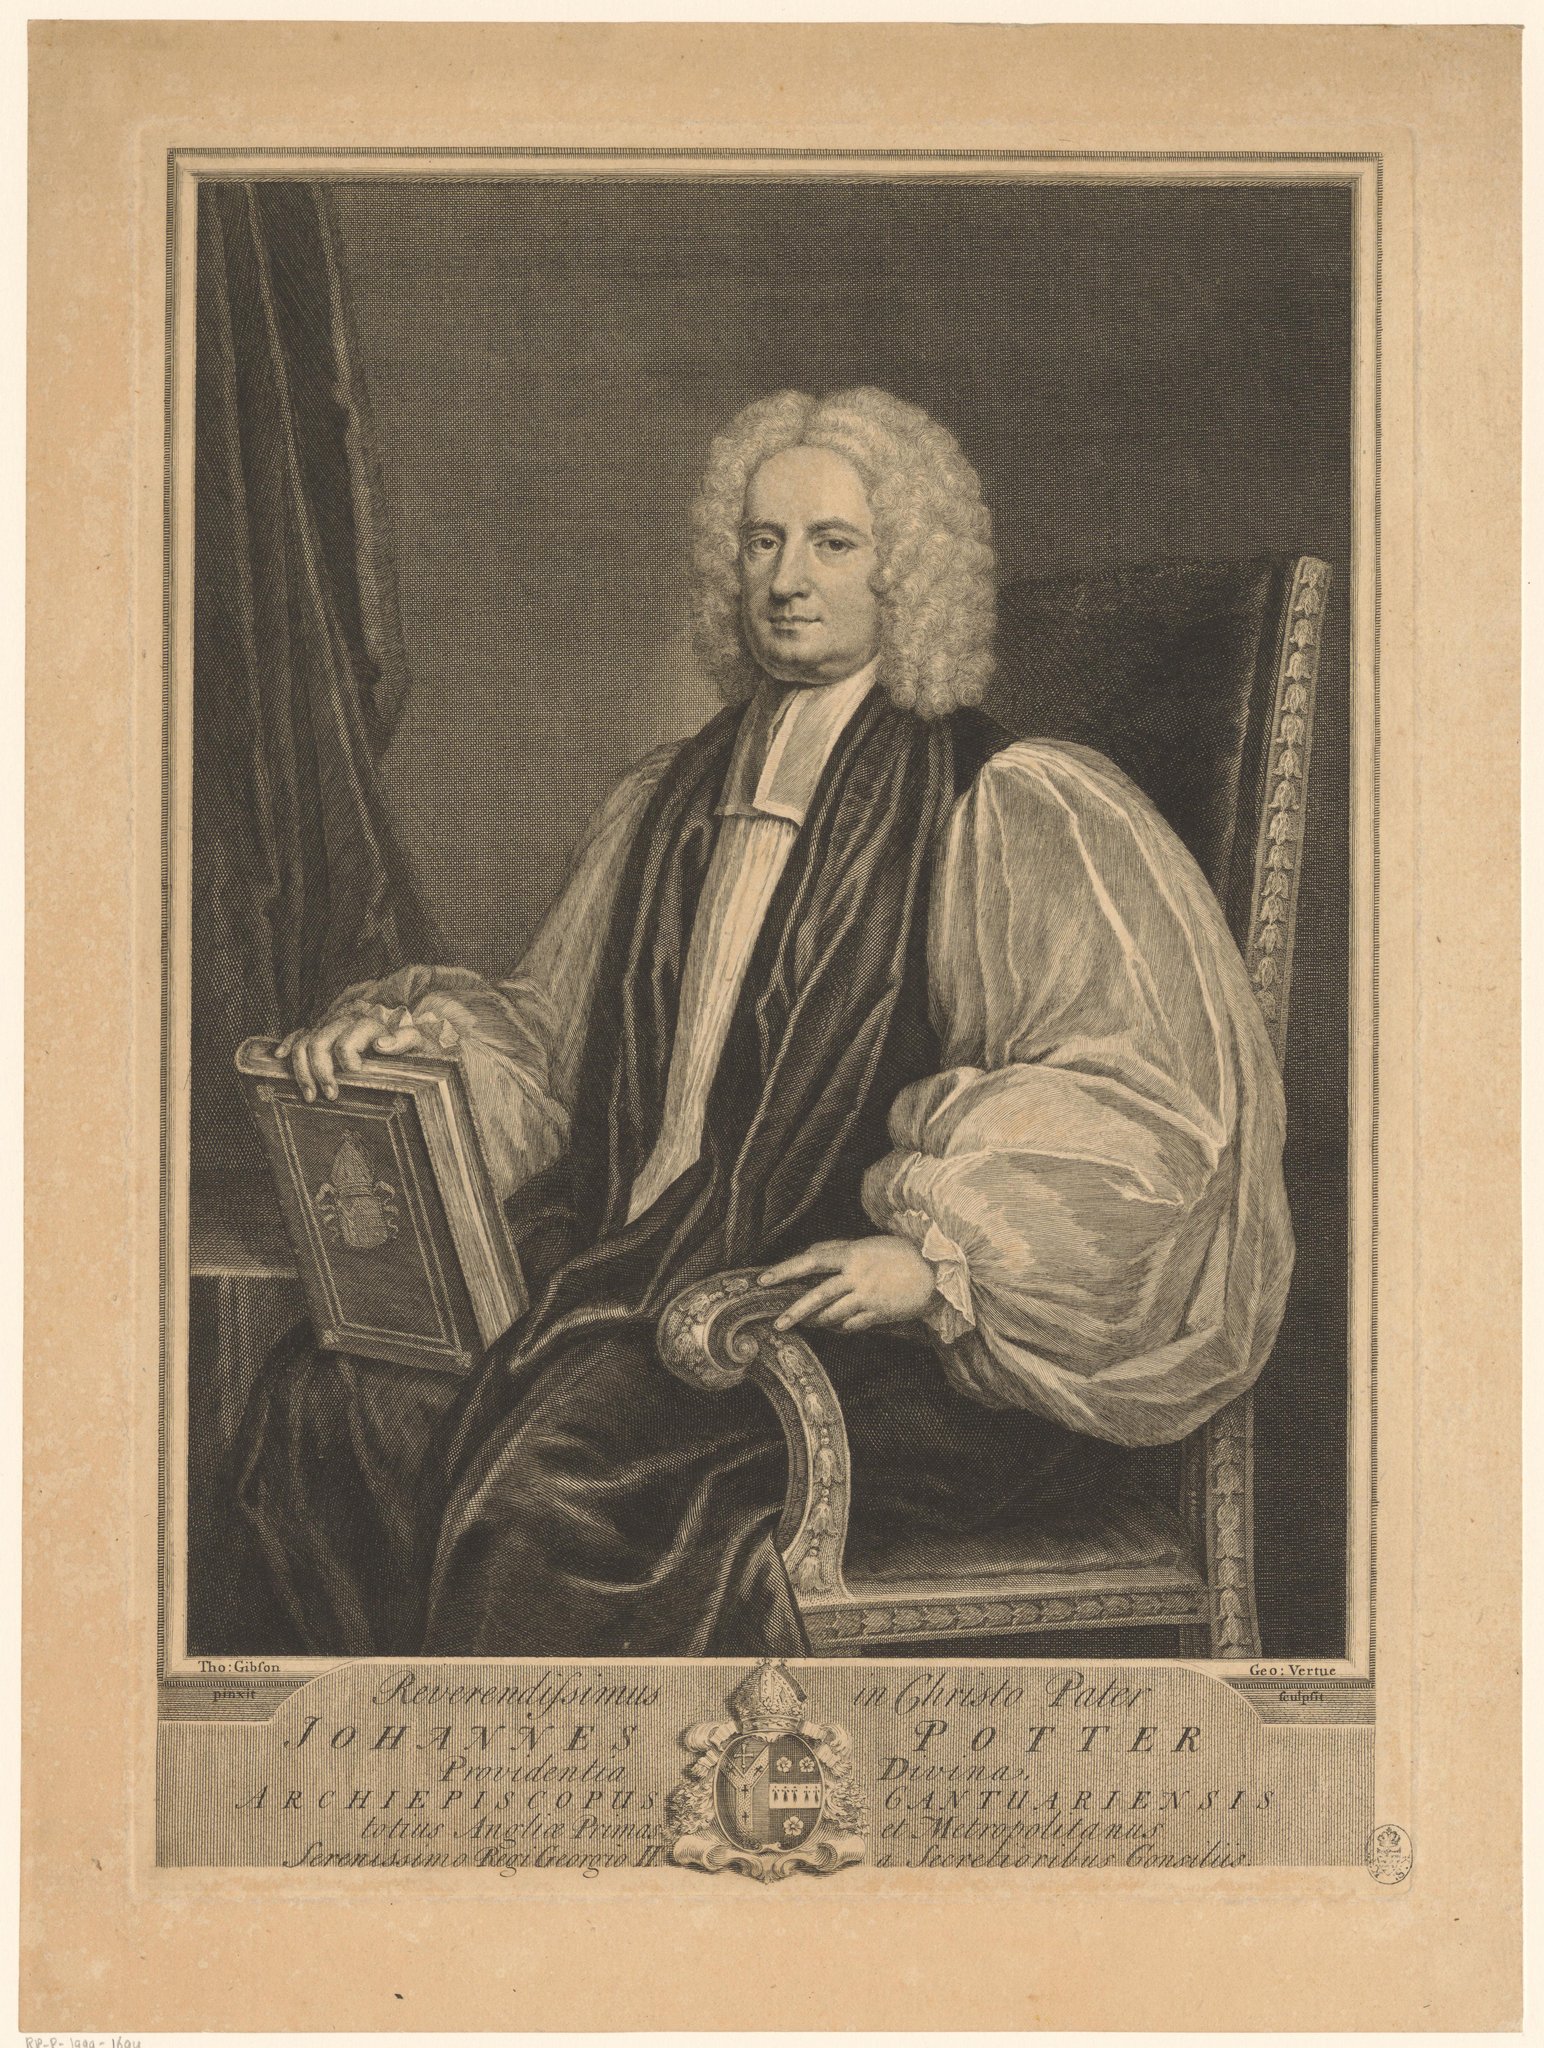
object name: print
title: Portret van Johannes Potter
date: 1694-1756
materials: paper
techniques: engraving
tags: archbishop, bishop, etc. (roman catholic), historical persons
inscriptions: collector's mark: Lugt 1647, collector's mark: Lugt 1647, collector's mark: Lugt 2228